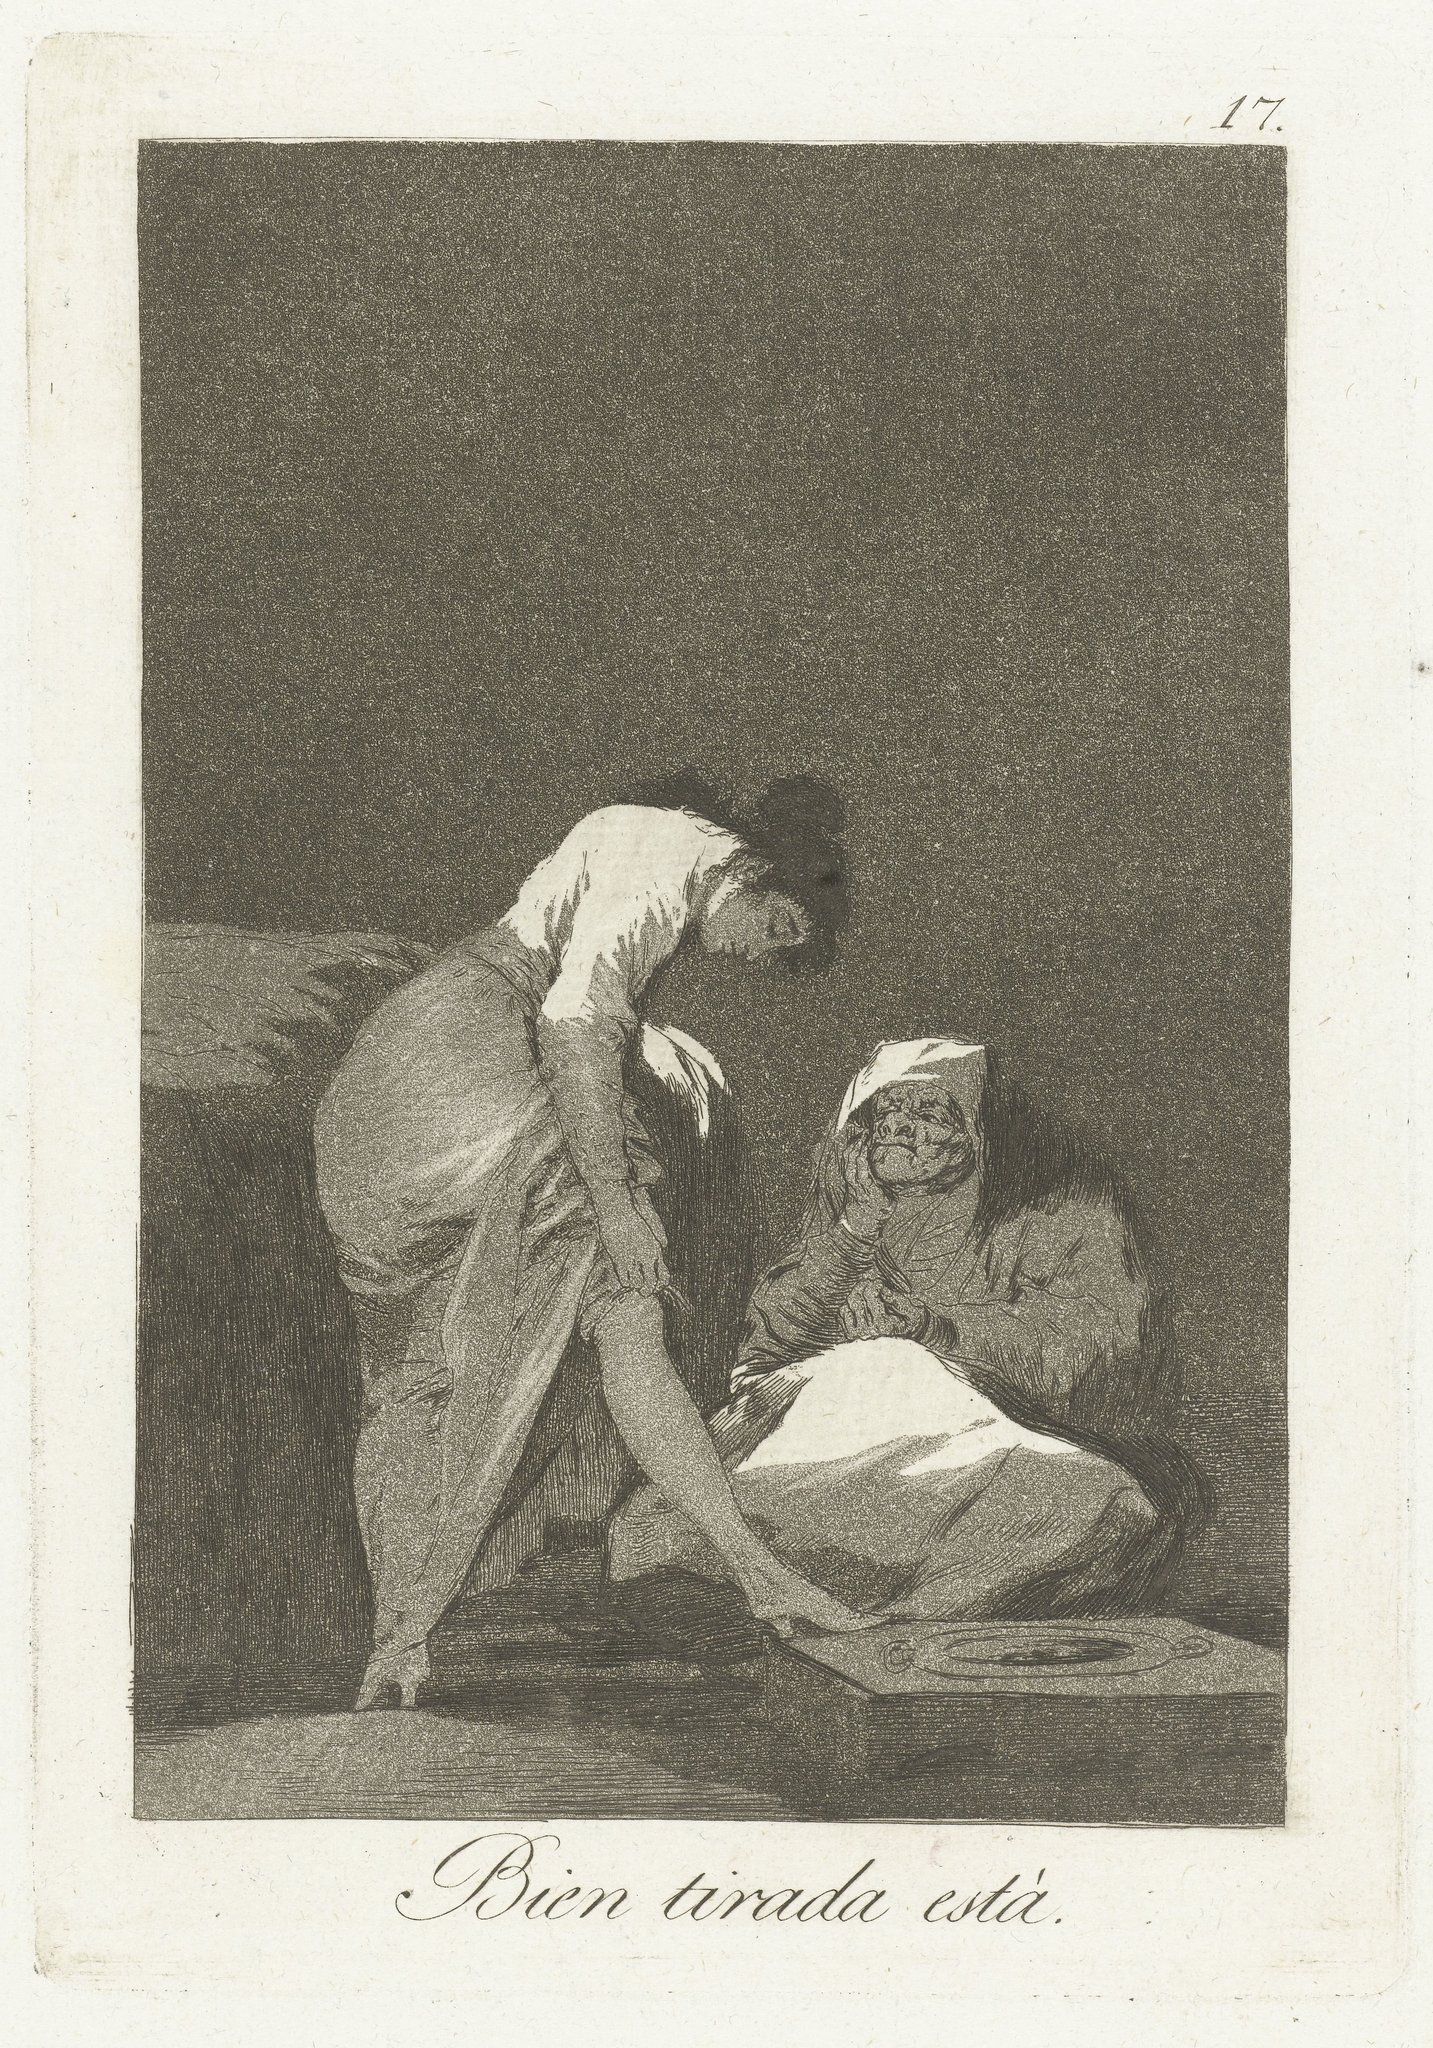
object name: print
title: Los Caprichos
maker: francisco de goya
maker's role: draughtsman, painter, print maker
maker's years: 1746-1828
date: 1797-1799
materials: paper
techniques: aquatint, etching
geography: spain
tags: adolescent, young woman, maiden, stockings, socks (+ dressing, putting on clothes), old woman, putting on or taking off stockings, stockings, socks (+ women's clothes)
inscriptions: collector's mark: Lugt 2228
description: Een jonge vrouw trekt haar kous omhoog. Een oude vrouw, zittend op de grond, kijkt toe. Zeventiende prent uit de serie Los Caprichos.